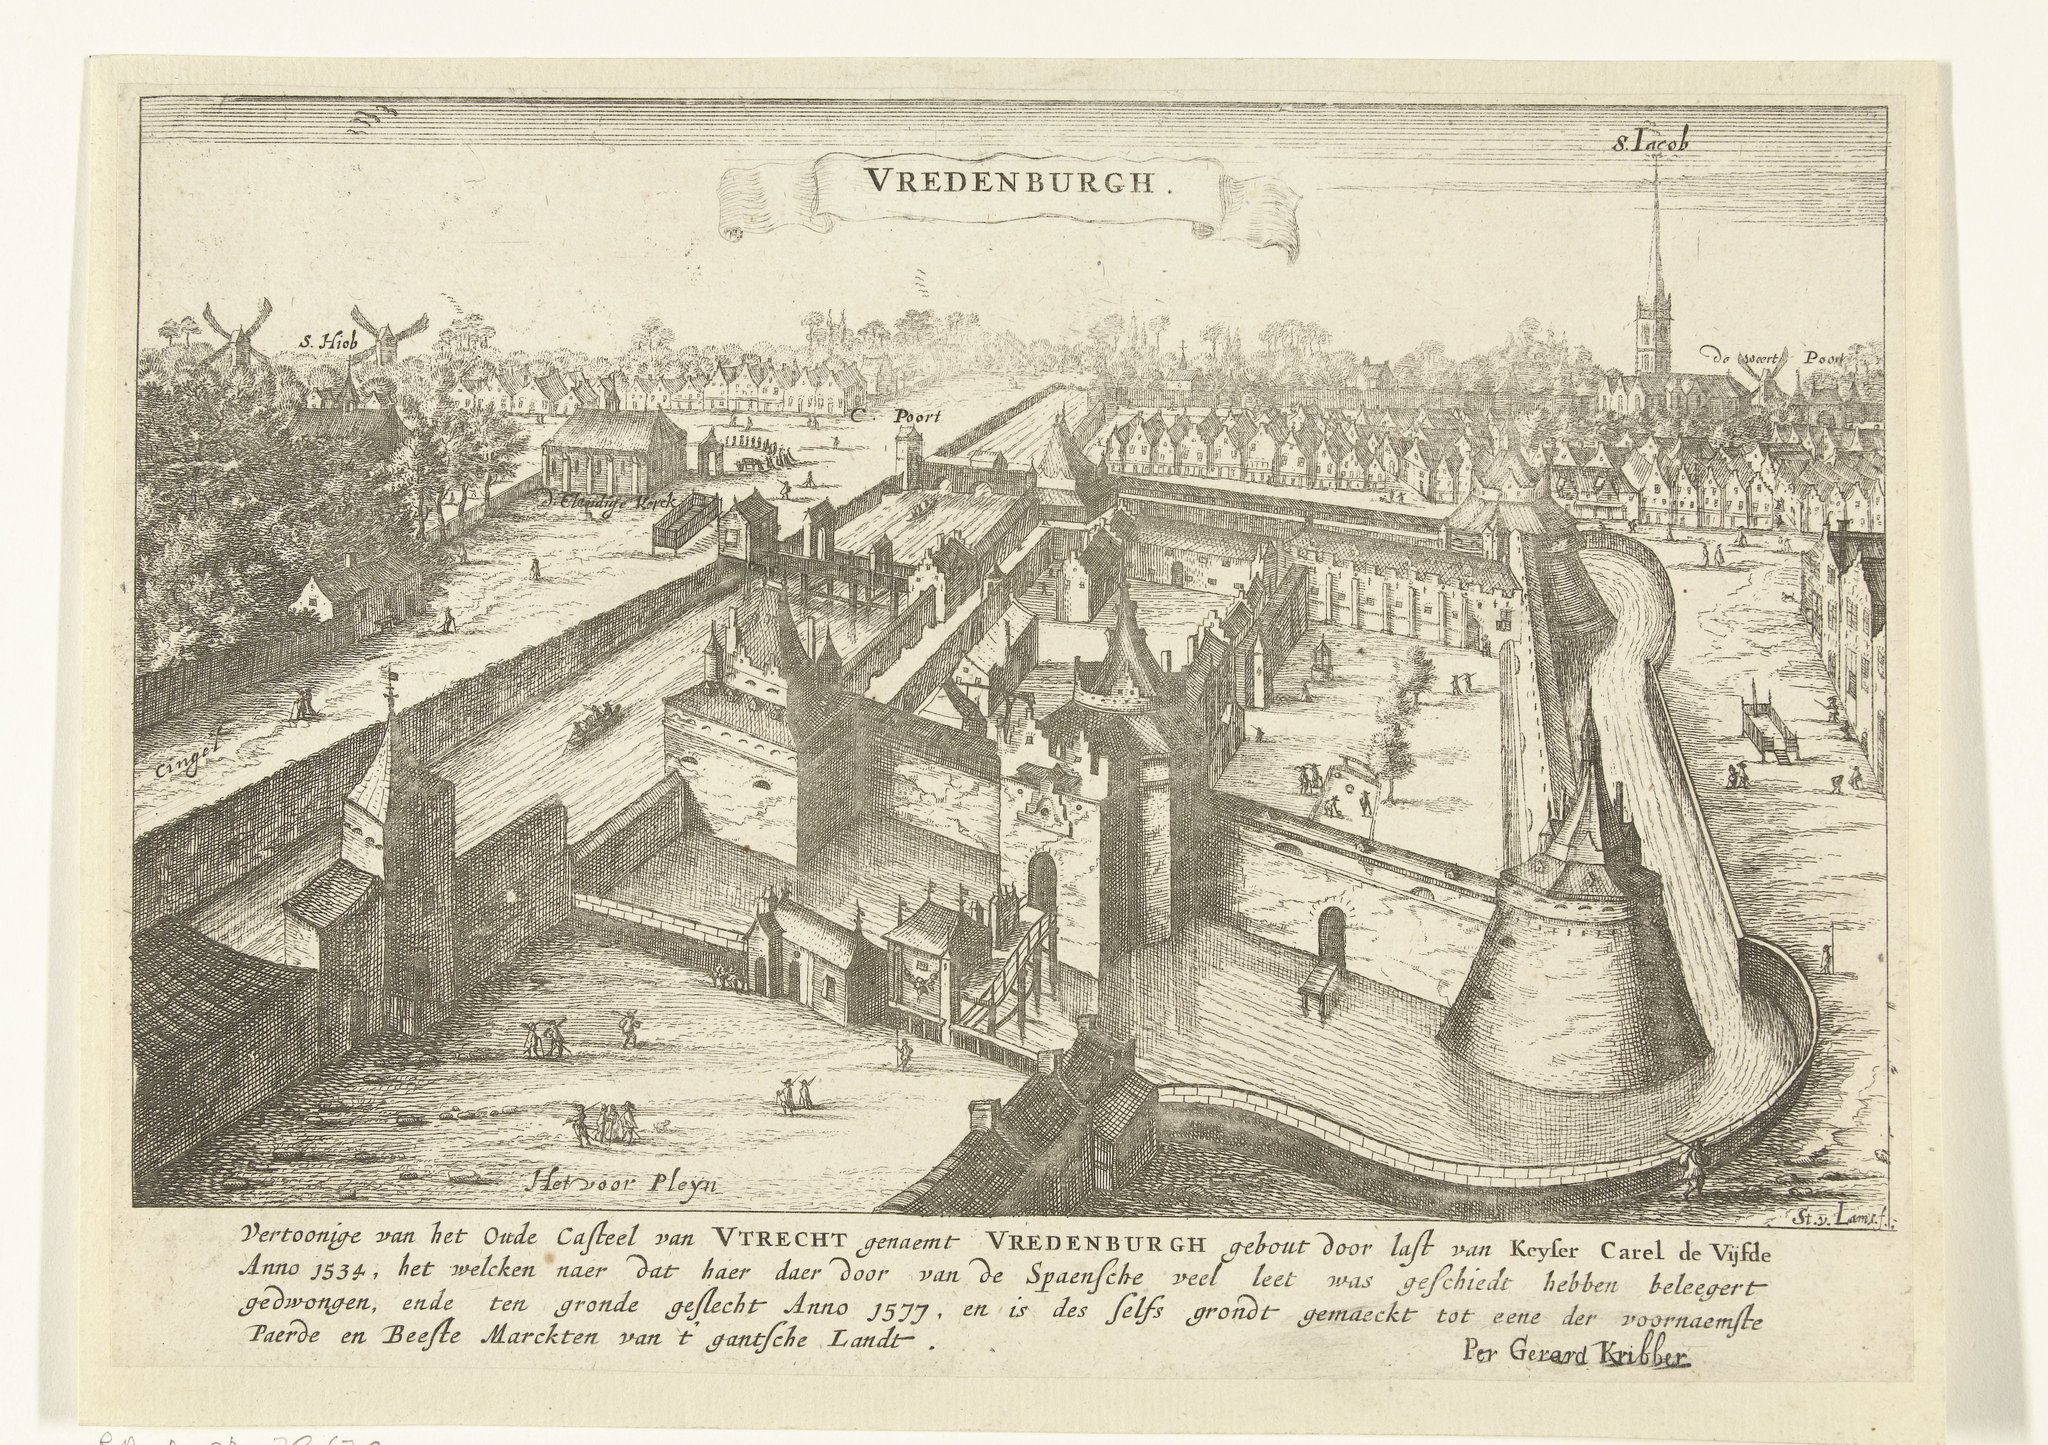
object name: history print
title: Slot Vredenburg te Utrecht in welstand, vóór 1577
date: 1707-1729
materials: paper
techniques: engraving, etching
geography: utrecht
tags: castle, fortifications, military engineering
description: Gezicht op het Slot Vredenburg te Utrecht in welstand, vóór het beleg en het slechten in 1577. Achter het Slot ligt de stad Utrecht waar enkele gebouwen met namen zijn geduid. Onder de voorstelling staat een vierregelig onderschrift in het Nederlands.